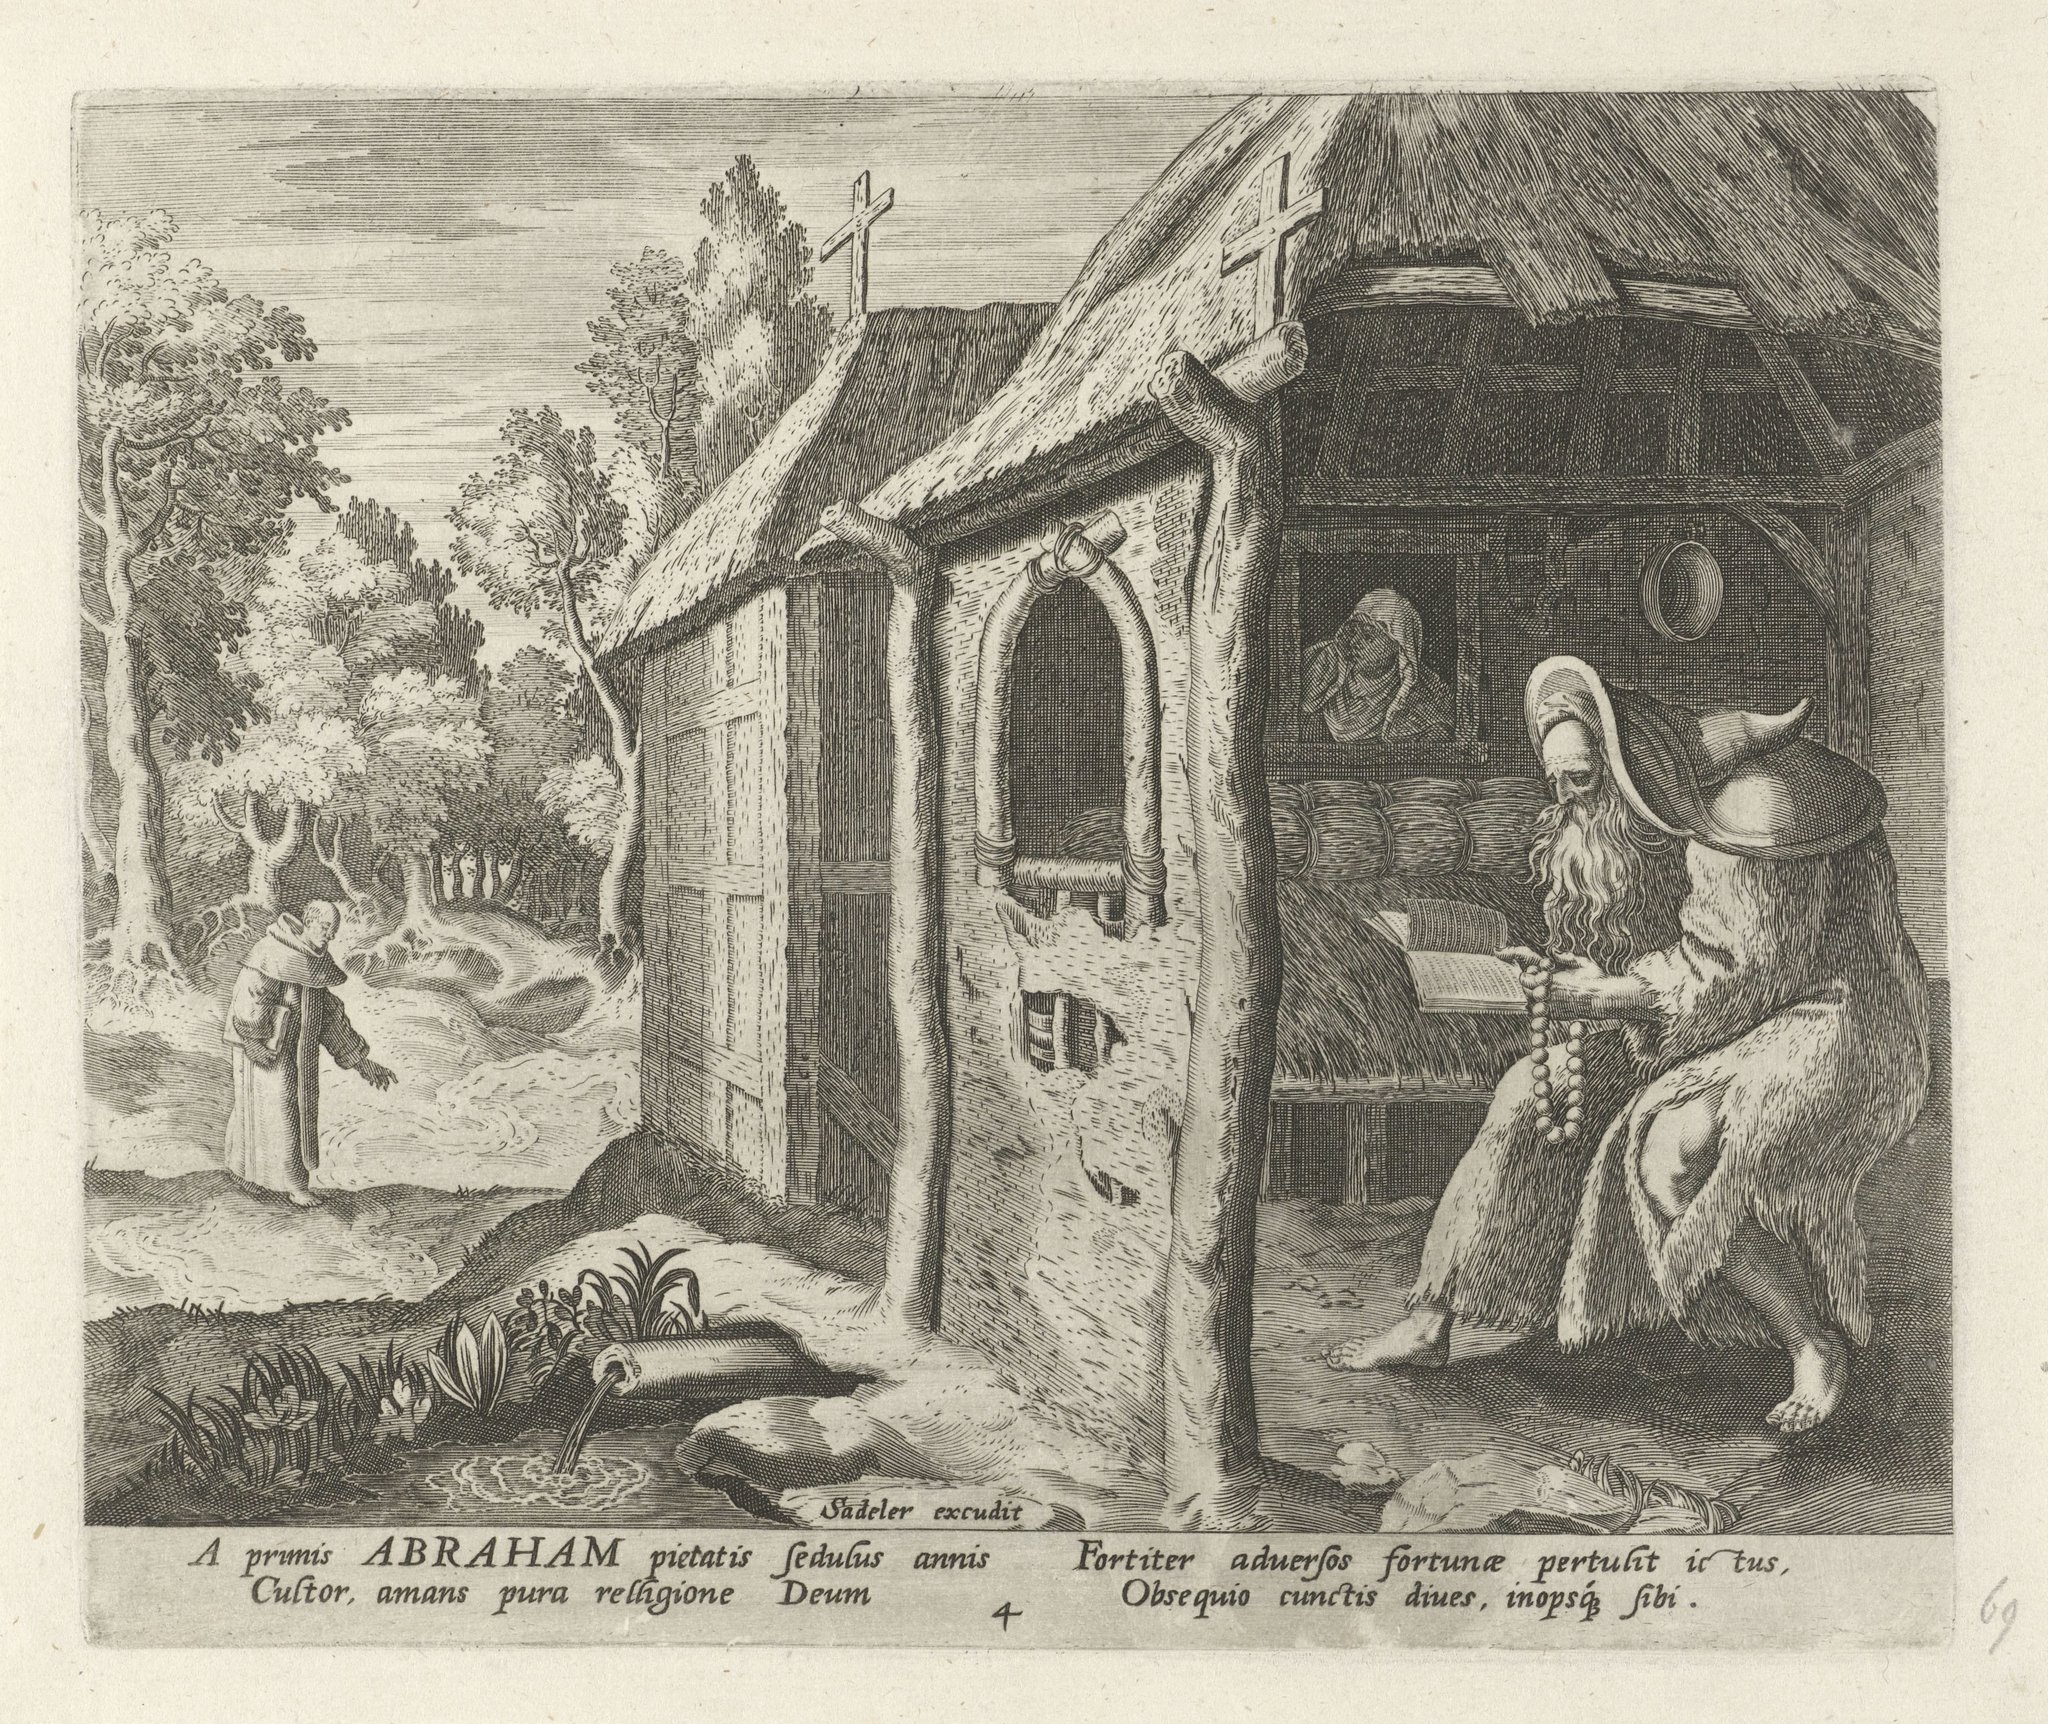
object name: print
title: Solitudo Sive Vitae Patrum Eremicolarum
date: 1583-1588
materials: paper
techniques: engraving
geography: antwerp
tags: anchorite, hermit, male saints (with name)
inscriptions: collector's mark: Lugt 2228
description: De H. Abraham als kluizenaar in een hutje. Hij leest uit een bijbel en heeft een rozenkrans vast. Achter hem zijn nicht, de H. Maria van Edessa. Op de achtergrond wandelt een monnik.